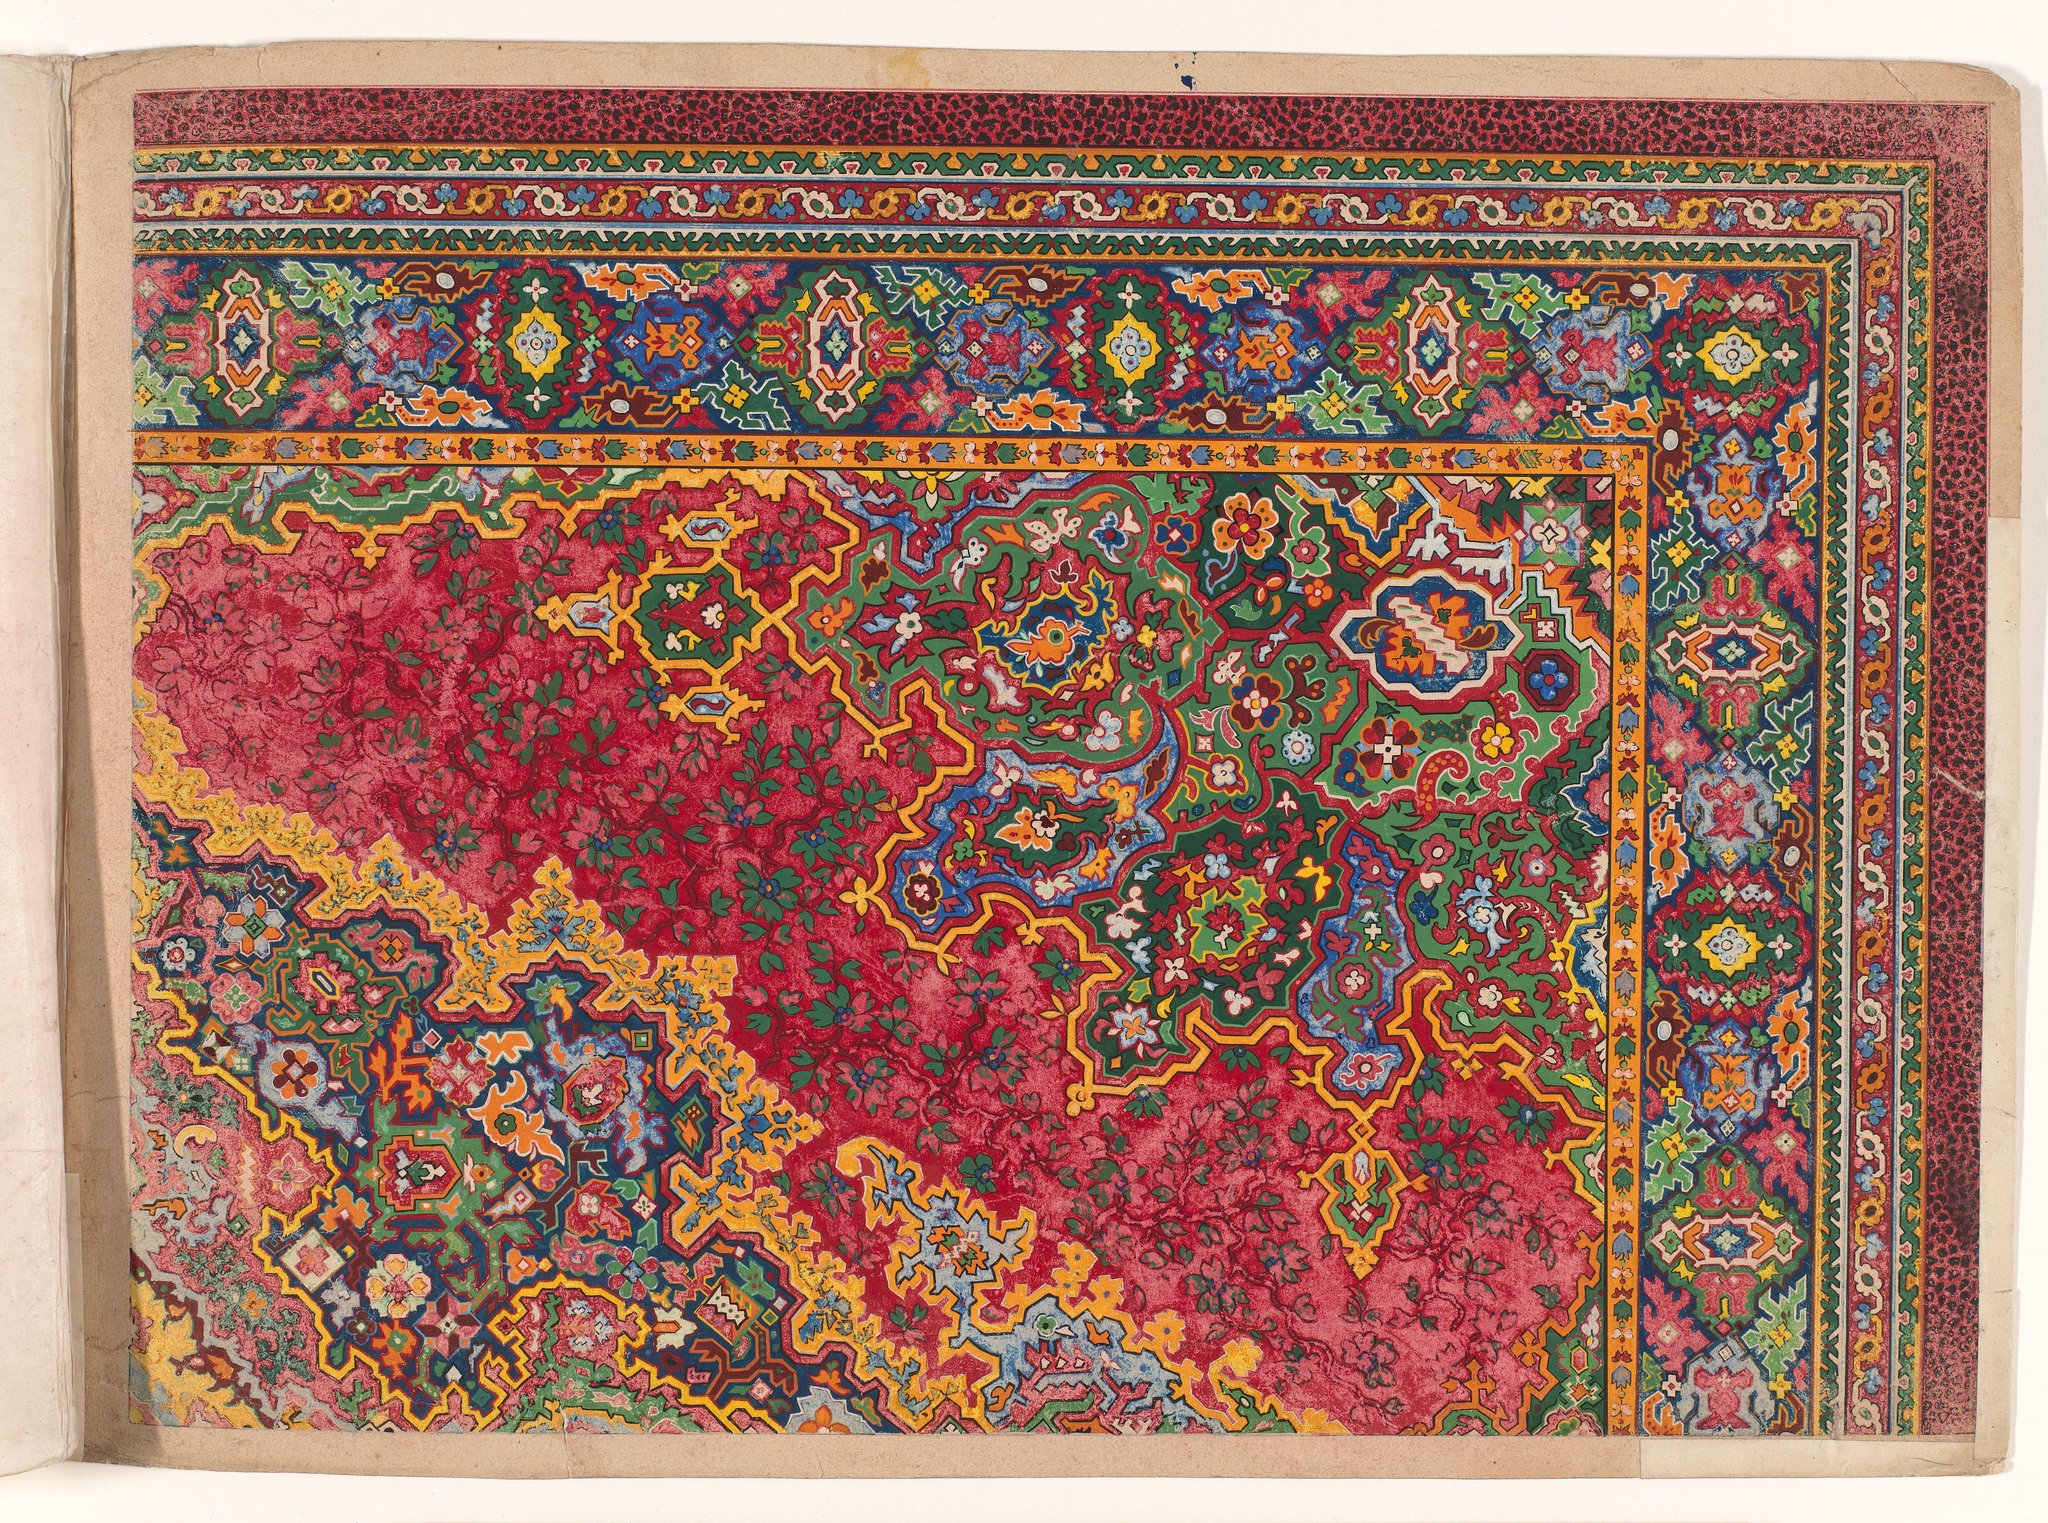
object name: design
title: Ontwerp voor een tapijt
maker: Anonymous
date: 1854-1864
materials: gouache, paper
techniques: brush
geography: deventer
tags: ornaments ~ art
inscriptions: inscription: ‘Keu[...] Lang 5,35 x [...]/ Breedte 4,45’, inscription: ‘U II/ 54’, retailer's mark: ‘JHS.’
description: De presentatietekeningen BK-1971-77-1 t/m 86 zijn kopieën van de originele ontwerptekeningen. Ze werden gemaakt voor vertegenwoordigers van bijvoorbeeld magazijnen, die ze aan hun klanten konden tonen. De meeste tekeningen tonen een kwart van het dessin inclusief rand, middenpartij (de zogenaamde grond of fond) en centraal medaillon. Door het gebruik van spiegels kan de illusie van het gehele tapijt worden opgeroepen. Een deel van de tekeningen heeft een alfabetische opeenvolgende letter als kenmerk, de andere groep een cijfer.Waarschijnlijk is de reeks dessins met een letter eerder samengesteld dan de genummerde tekeningen.